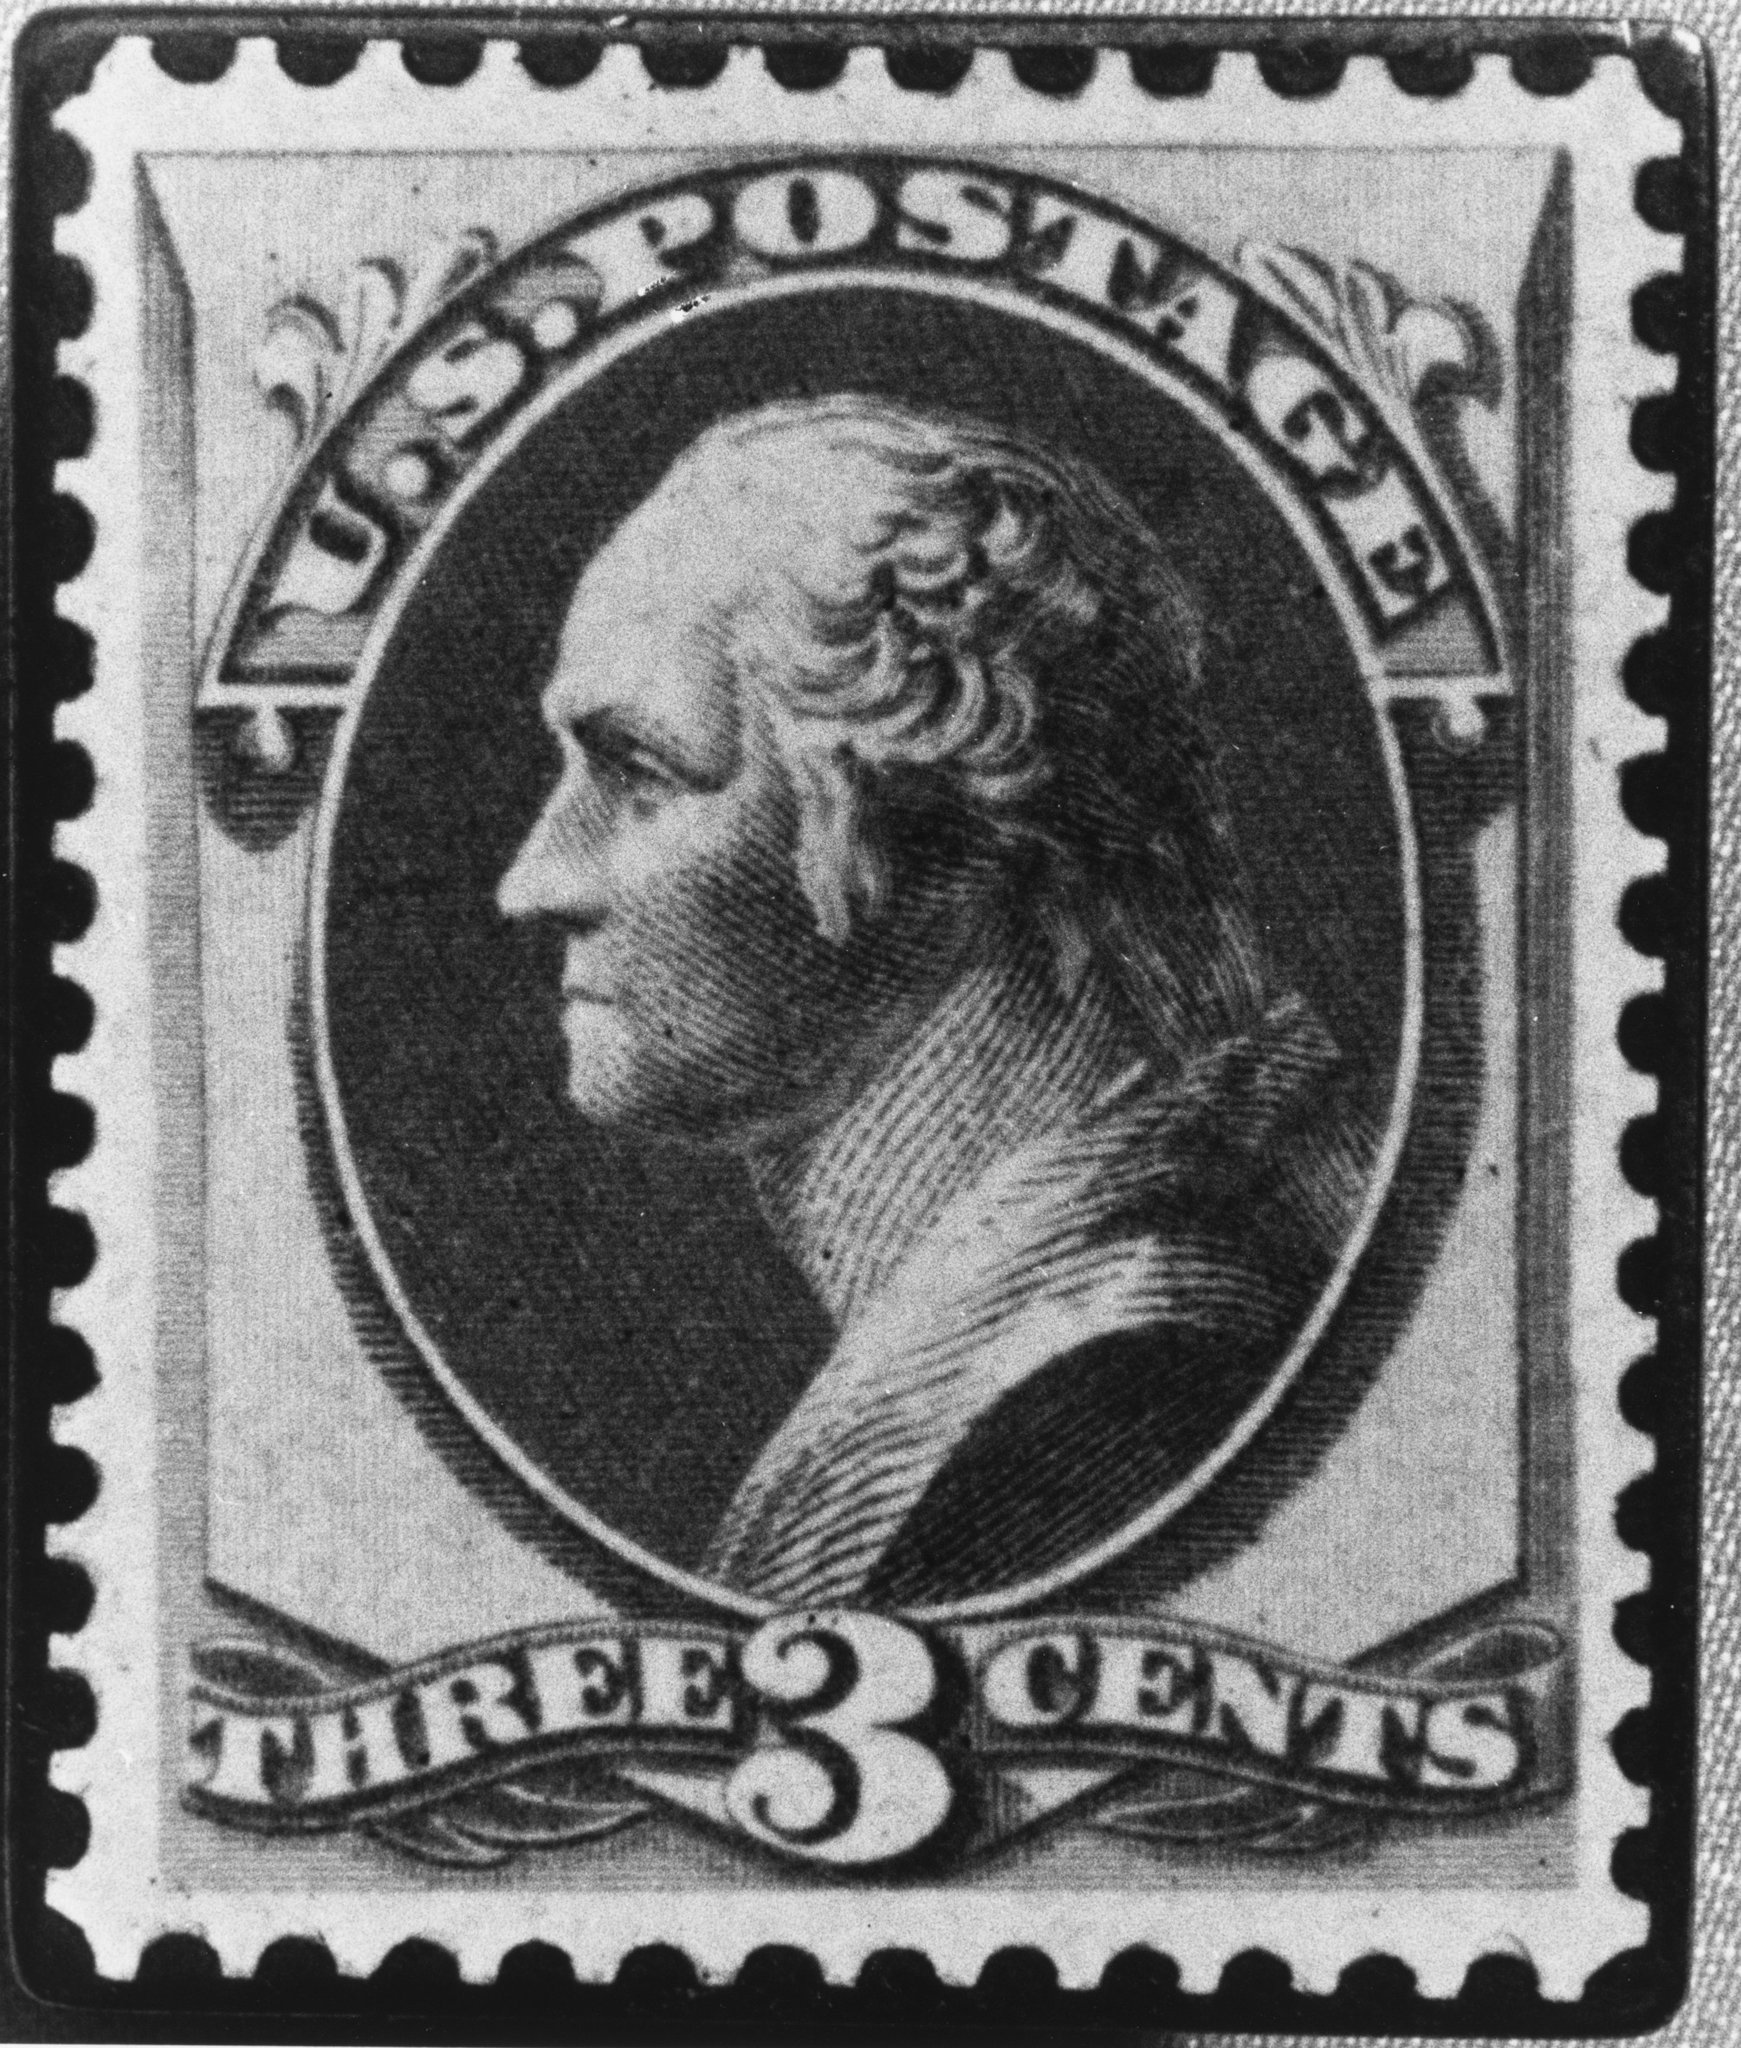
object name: stamp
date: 1800-1883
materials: enamel, silver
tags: men,profiles